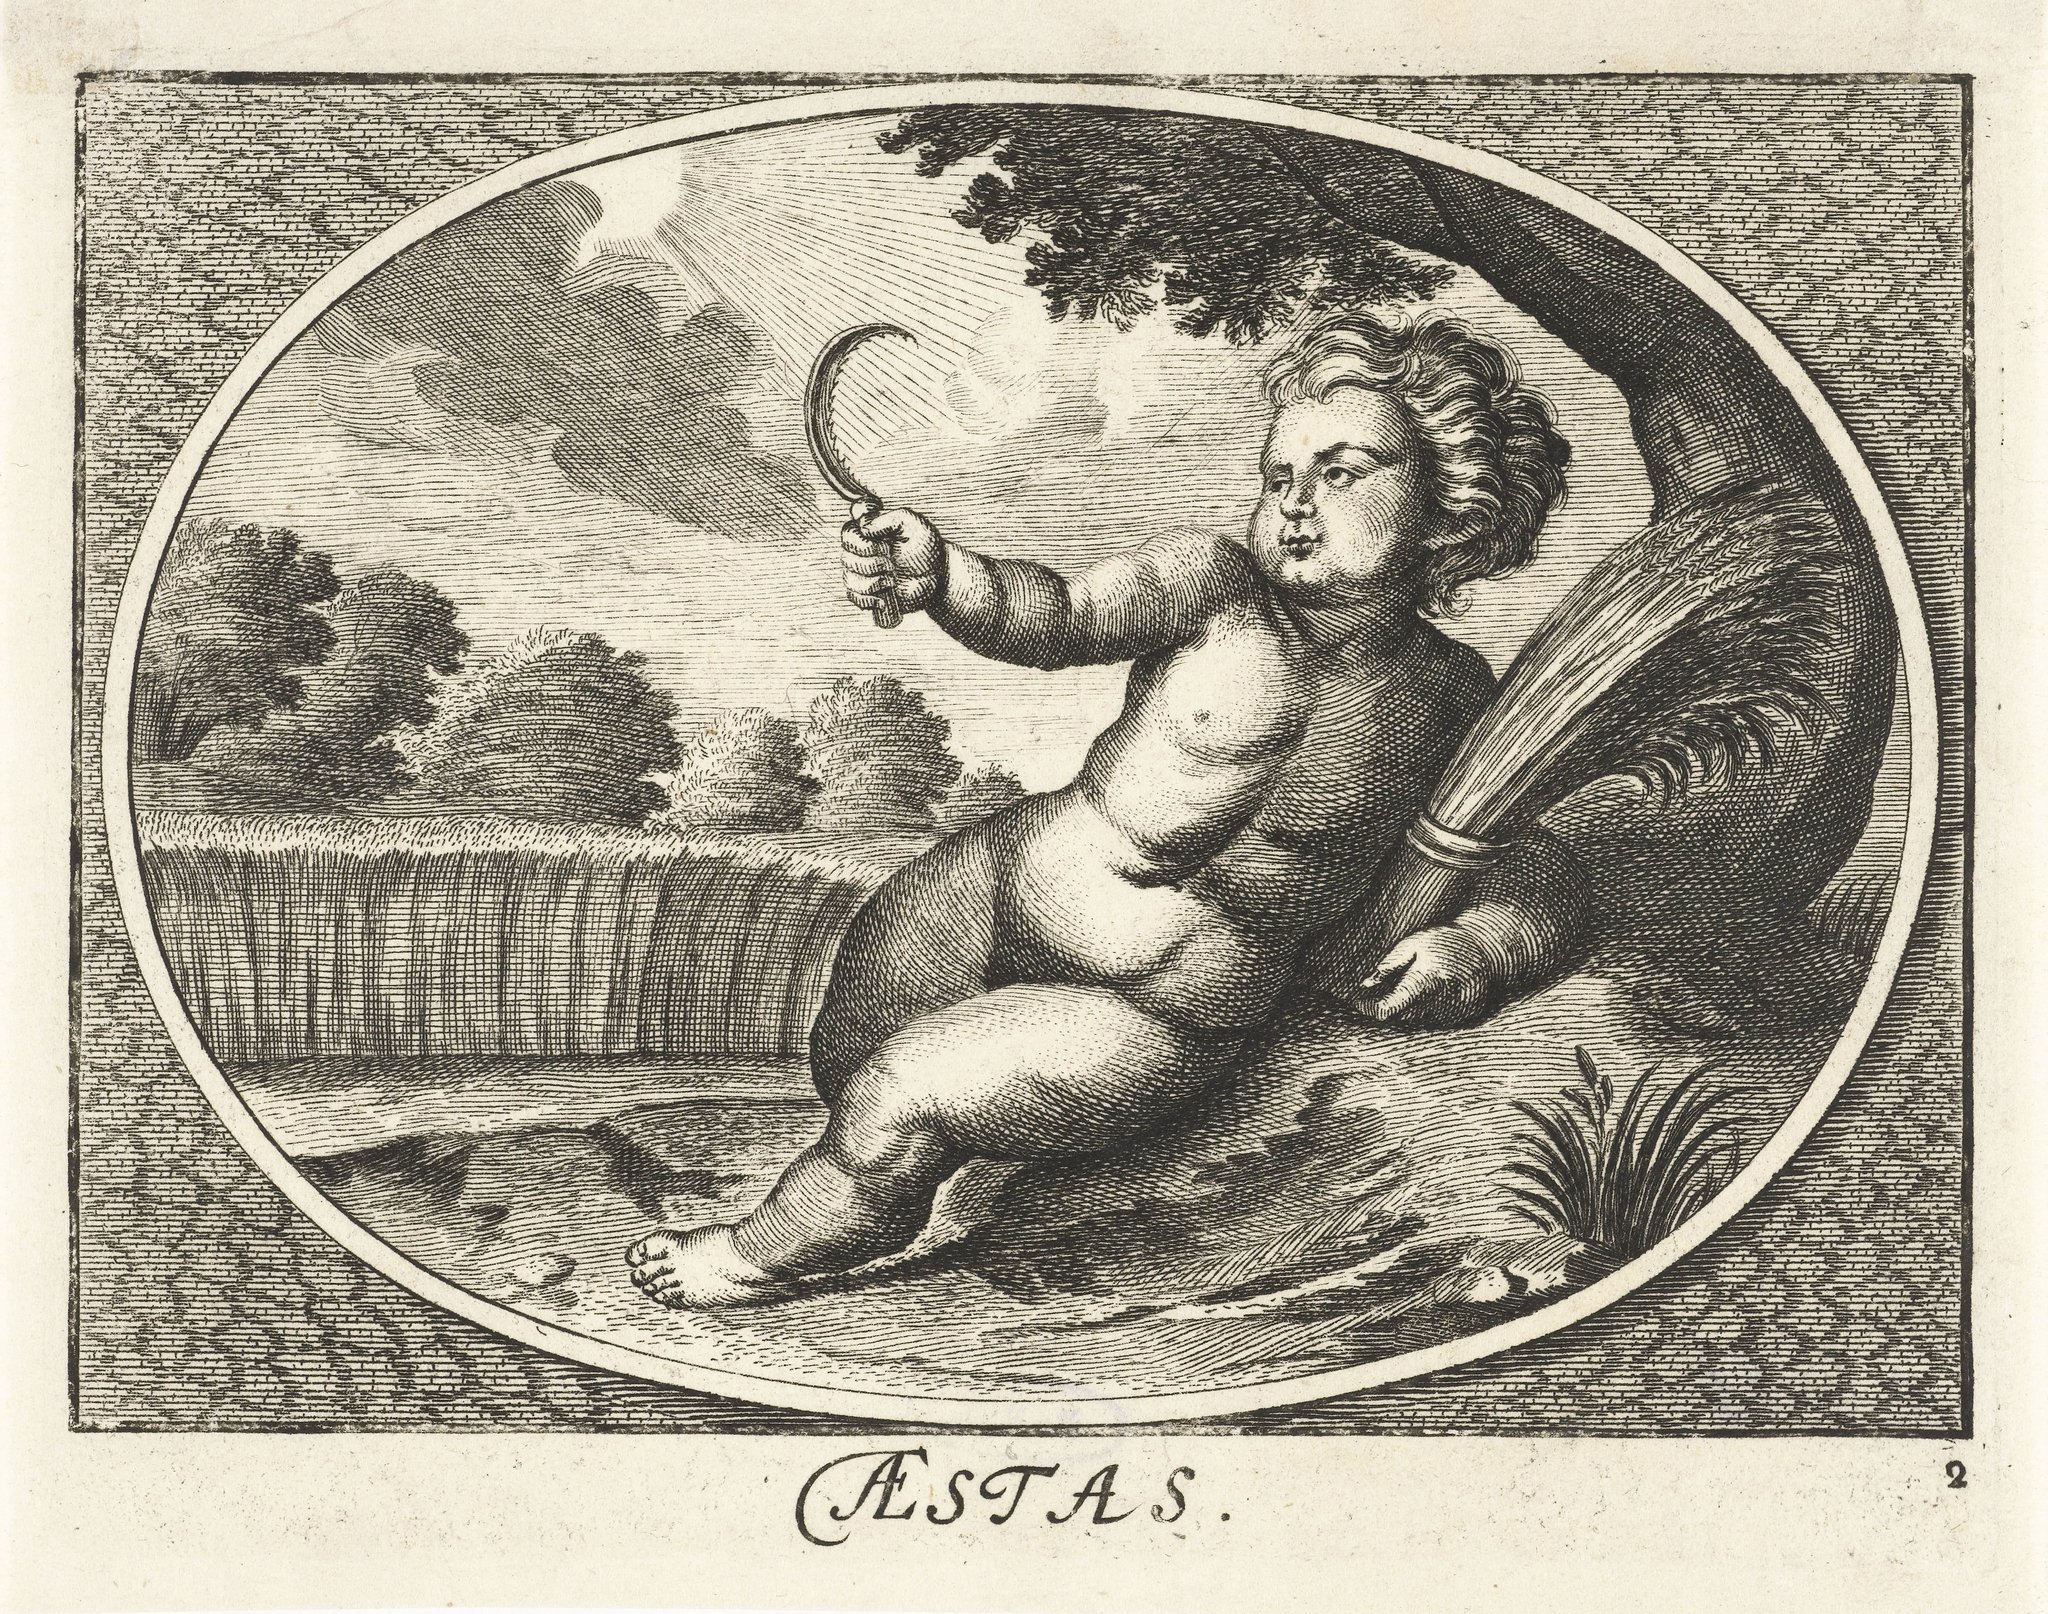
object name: print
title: Aestas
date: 1735-1750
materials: paper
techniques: engraving, etching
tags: summer, 'aestas'; 'estate' (ripa)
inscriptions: collector's mark: Lugt 2228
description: Kopie naar prent van Cornelis van Dalen (II) uit serie van vier prenten met de vier jaargetijden.